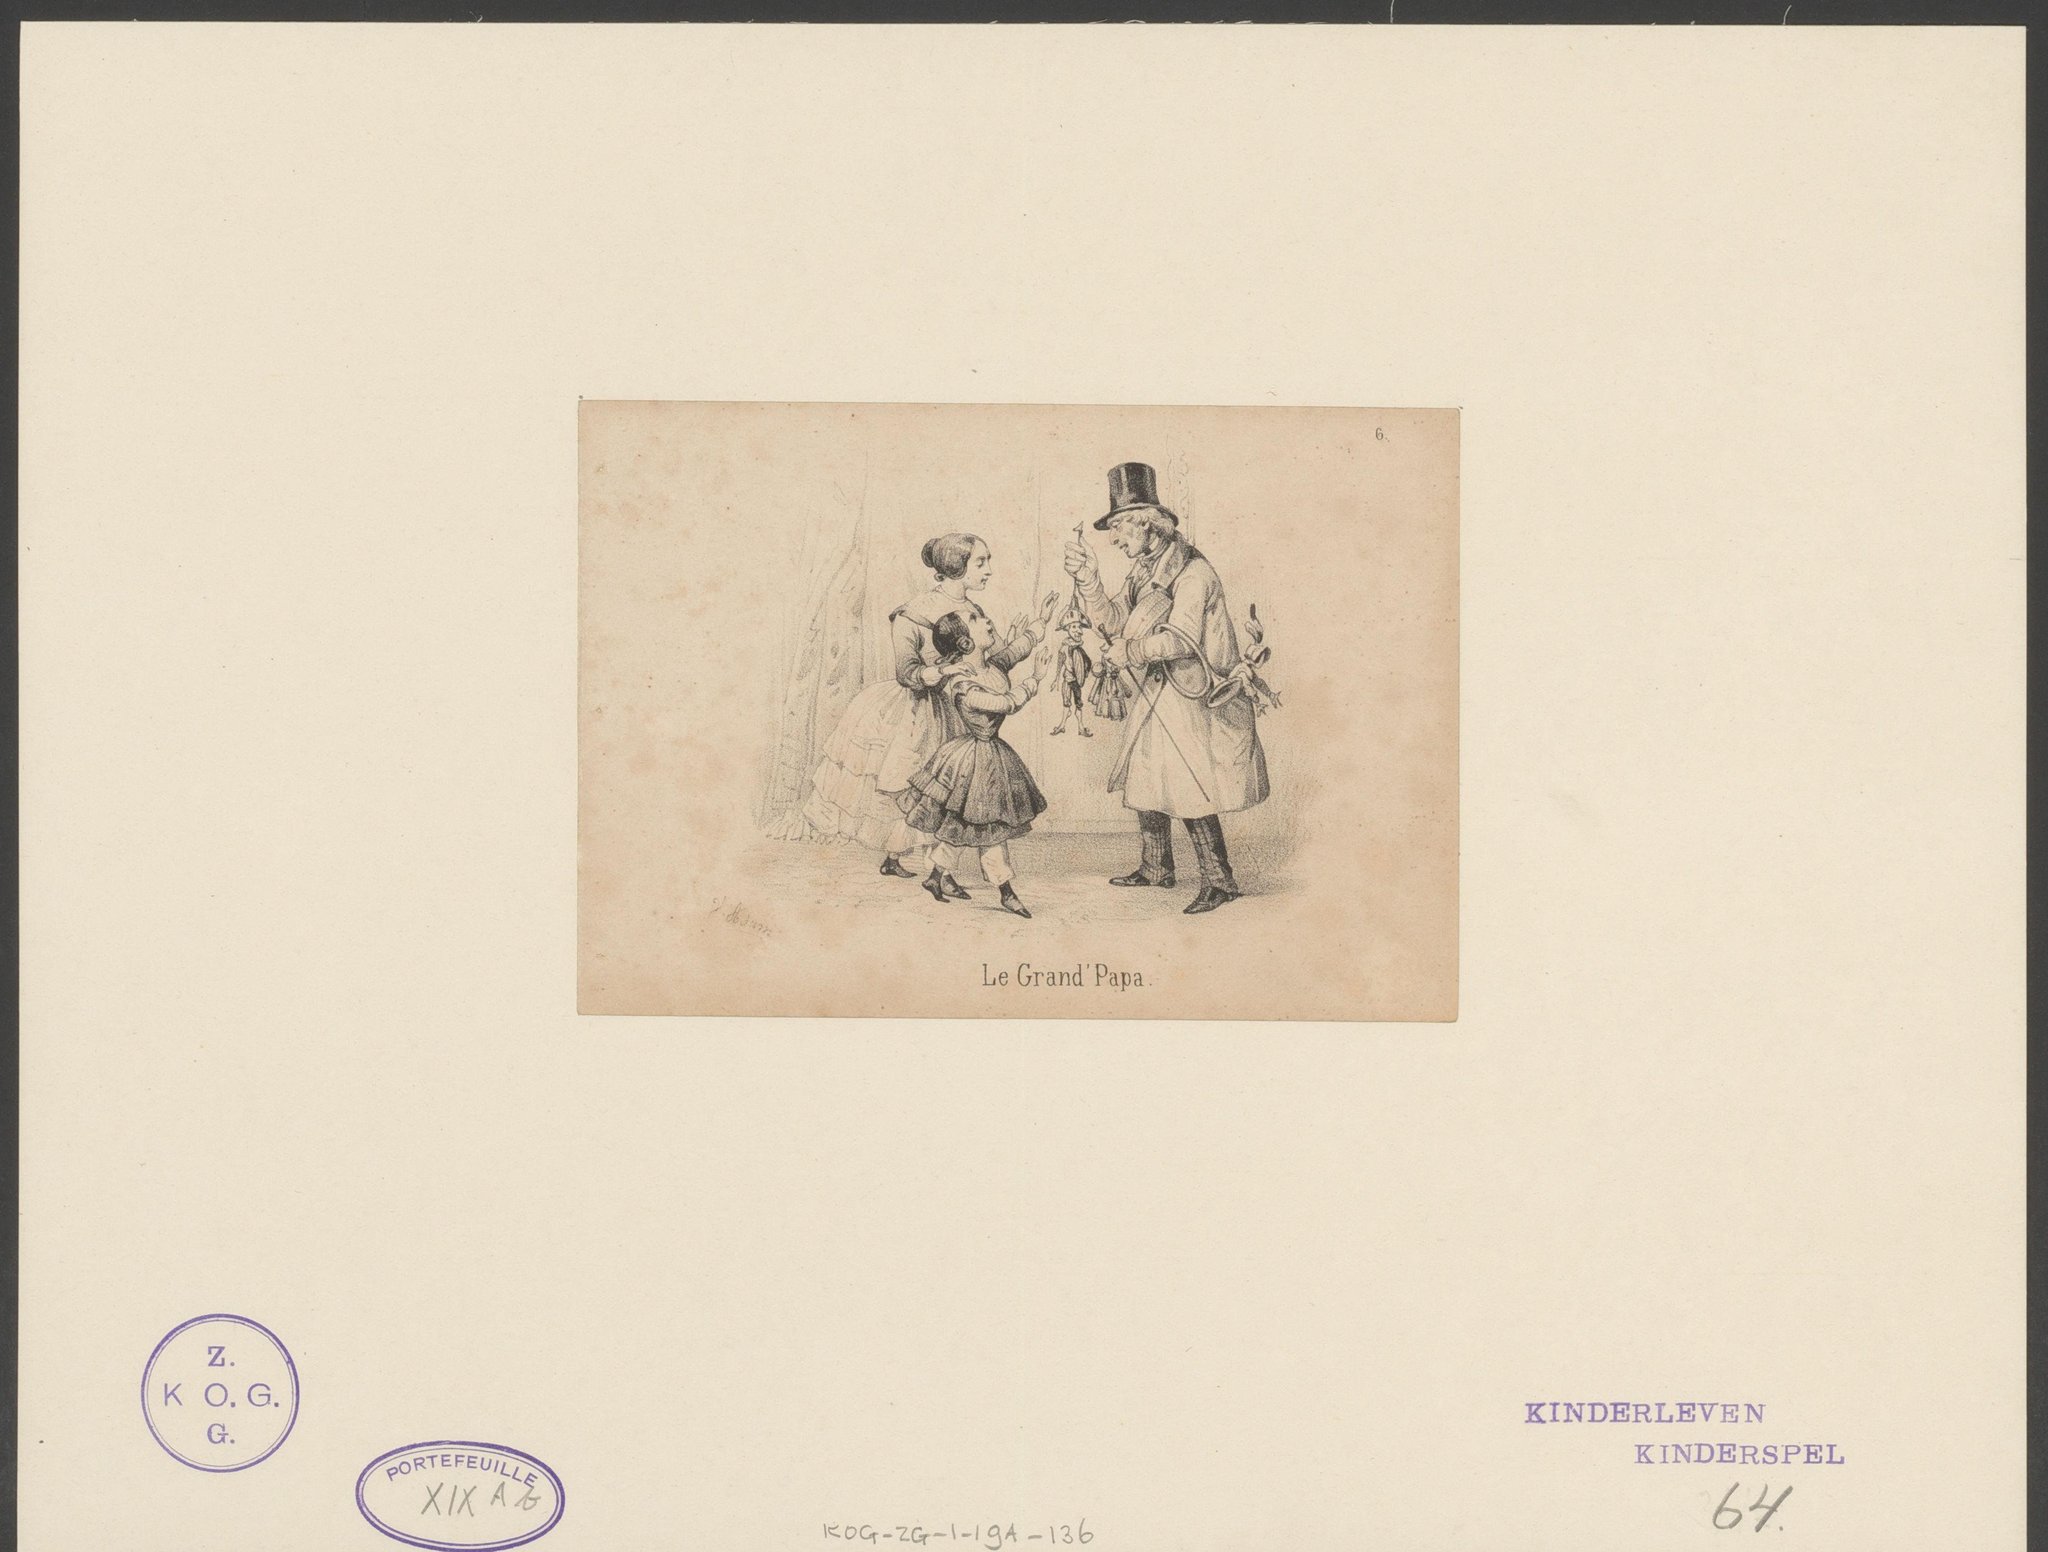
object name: print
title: Twee meisjes bij een man met poppen en een hoorn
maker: victor adam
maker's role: painter, print maker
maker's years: 1801-1866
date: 1811-1866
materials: paper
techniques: lithograph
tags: horn, trumpet, cornet, trombone, tuba, child, (playing with) dolls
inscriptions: collector's mark: Lugt 1641, stamp, stamp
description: Rechtsonder genummerd: 6. Onderwerpsrubrieken binnen de Atlas Zeden en Gewoonten: Zeden en Gewoonten in Engeren Zin, Des menschen beging, midden en einde, Kinderleven – Kinderspel en Kinderprenten.